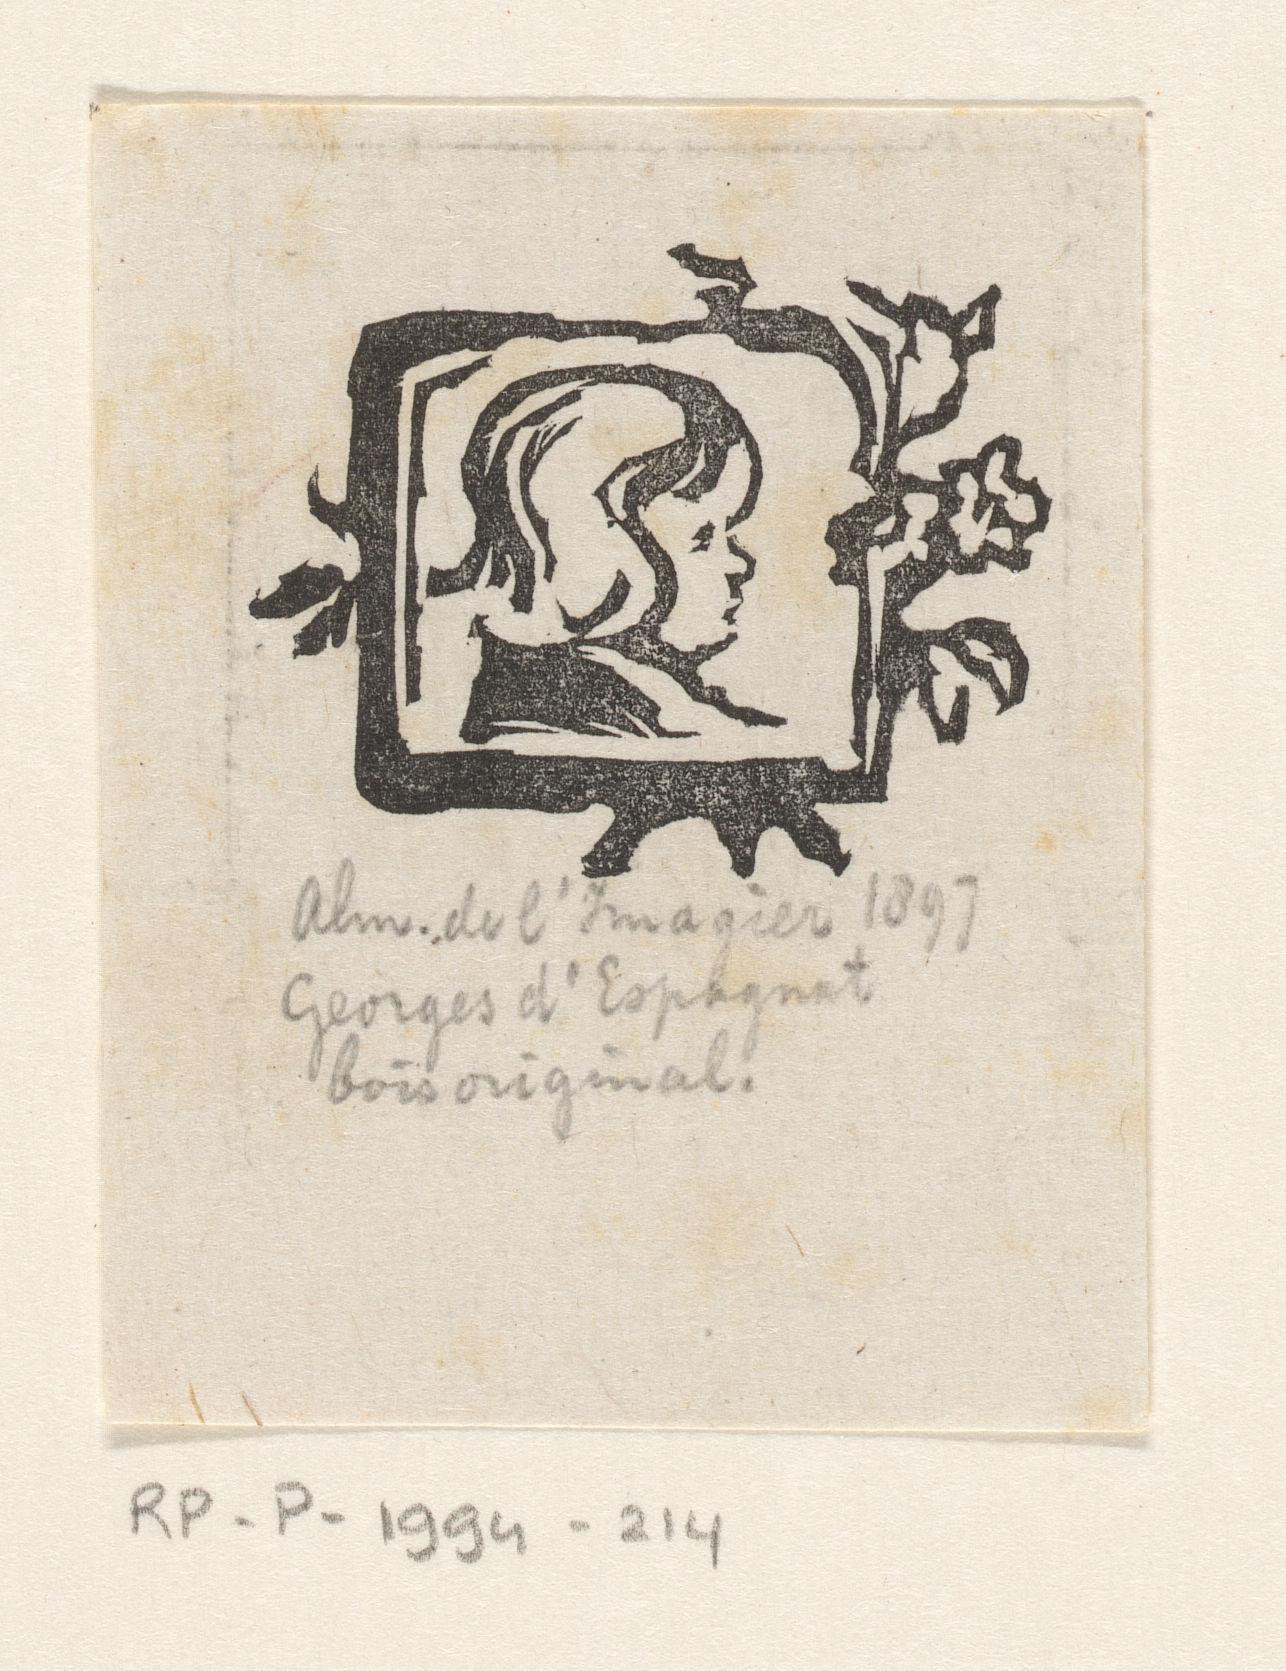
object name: print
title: Personificatie van de lente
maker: georges d espagnat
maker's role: print maker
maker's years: 1870-1950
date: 1897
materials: paper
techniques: woodcut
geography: paris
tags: spring, 'ver'; 'primavera' (ripa)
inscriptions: annotation: ‘Alm. de l'Imagier, 1897/ Georges d'Espagnat/ bois original’, collector's mark: Lugt 2228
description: Prent uit: Gourmont, Remy de. Almanach de l'Ymagier 1897. Parijs: L'Ymagier, 1897.